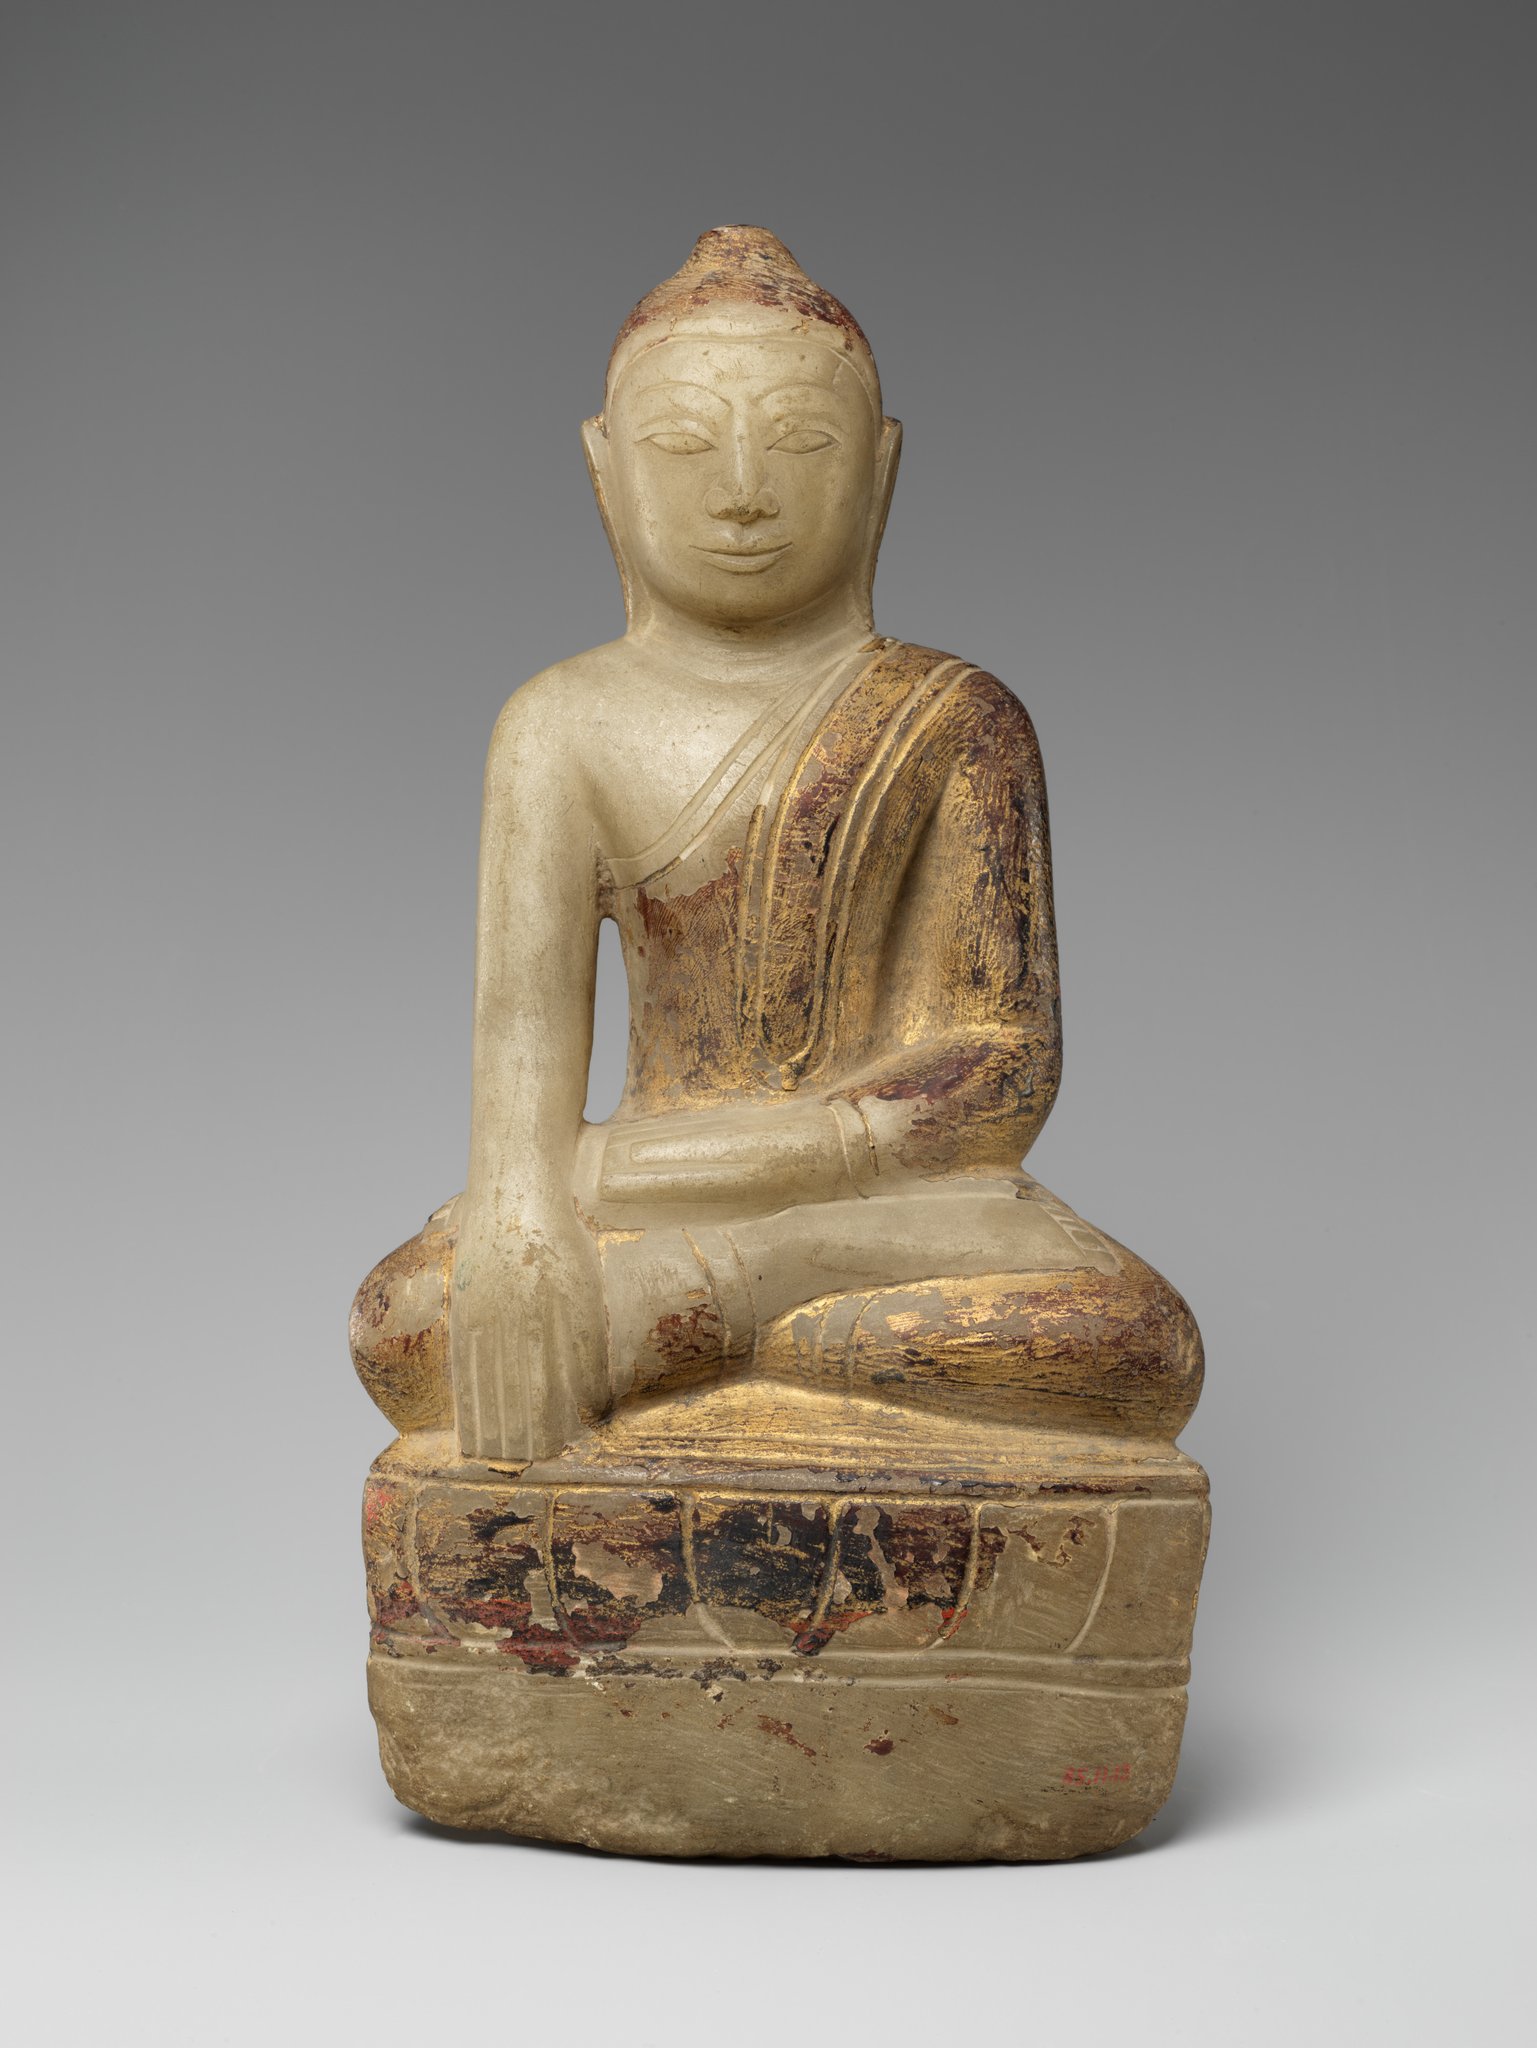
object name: statuette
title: Seated Buddha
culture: burmese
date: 1701-1800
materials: alabaster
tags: buddhism,buddha